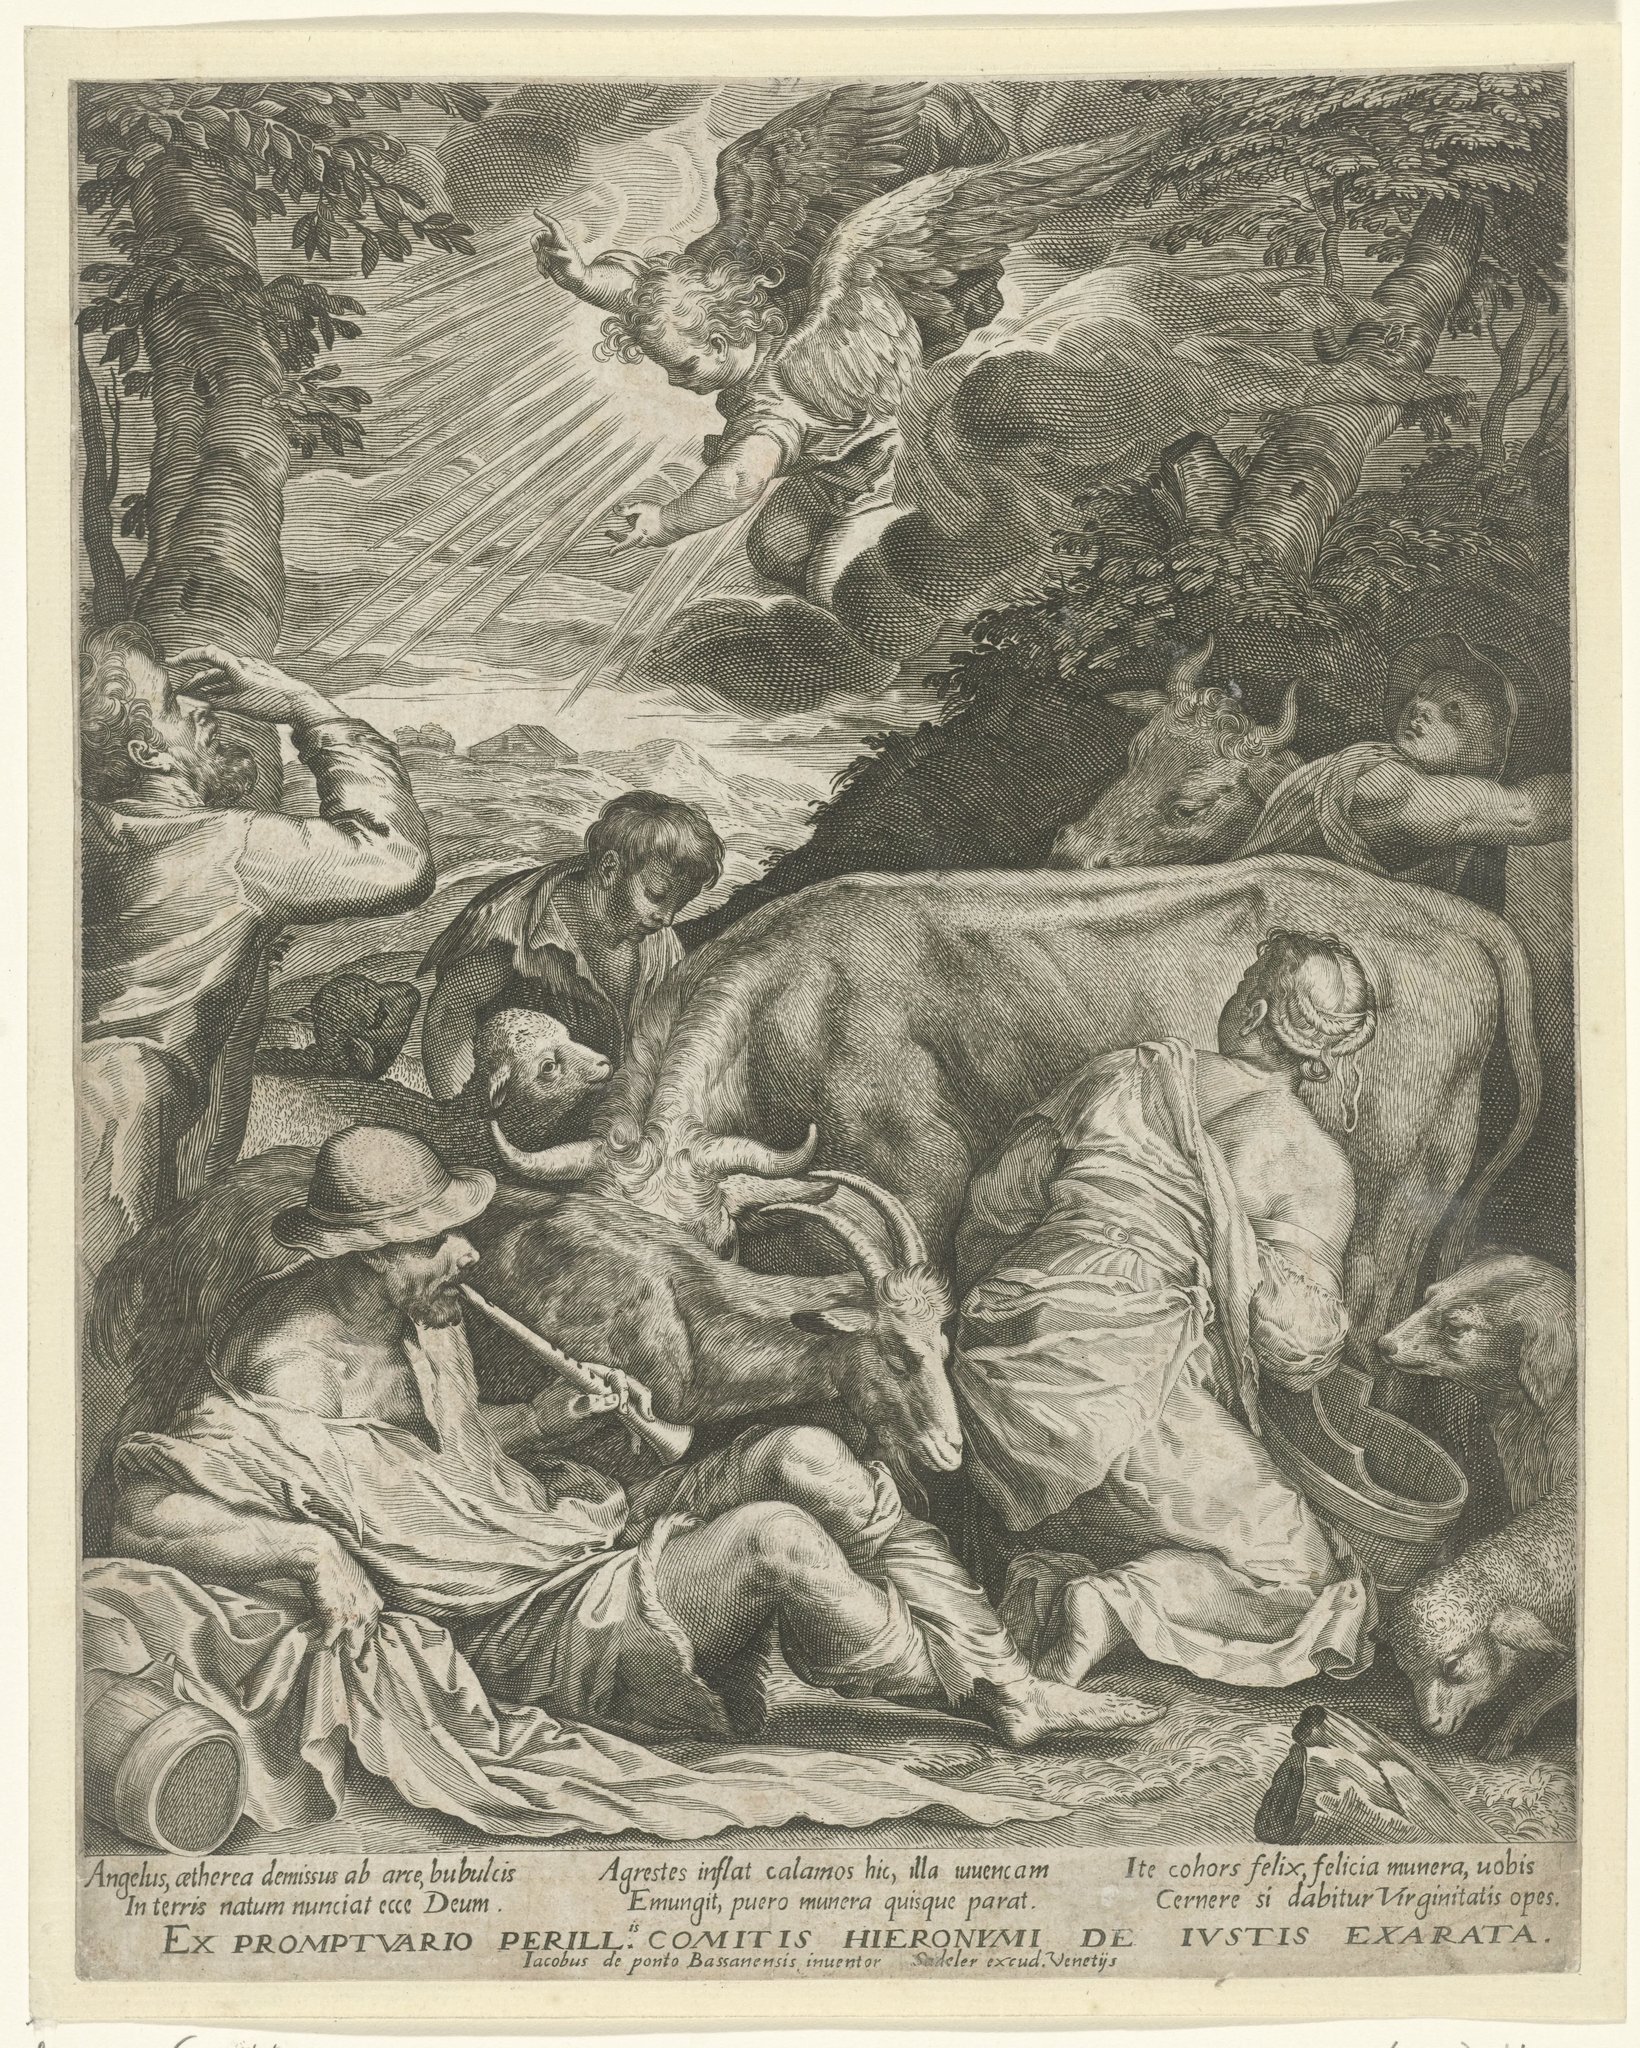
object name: print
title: Verkondiging aan de herders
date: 1593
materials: paper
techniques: engraving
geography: venice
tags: annunciation of christ's birth to the shepherds (and/or shepherdesses) at night; a host of singing angels in the air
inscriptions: collector's mark: Lugt 240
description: Een engel verkondigt de geboorte van Christus aan de herders. De prent heeft een Latijns onderschrift met uitleg.